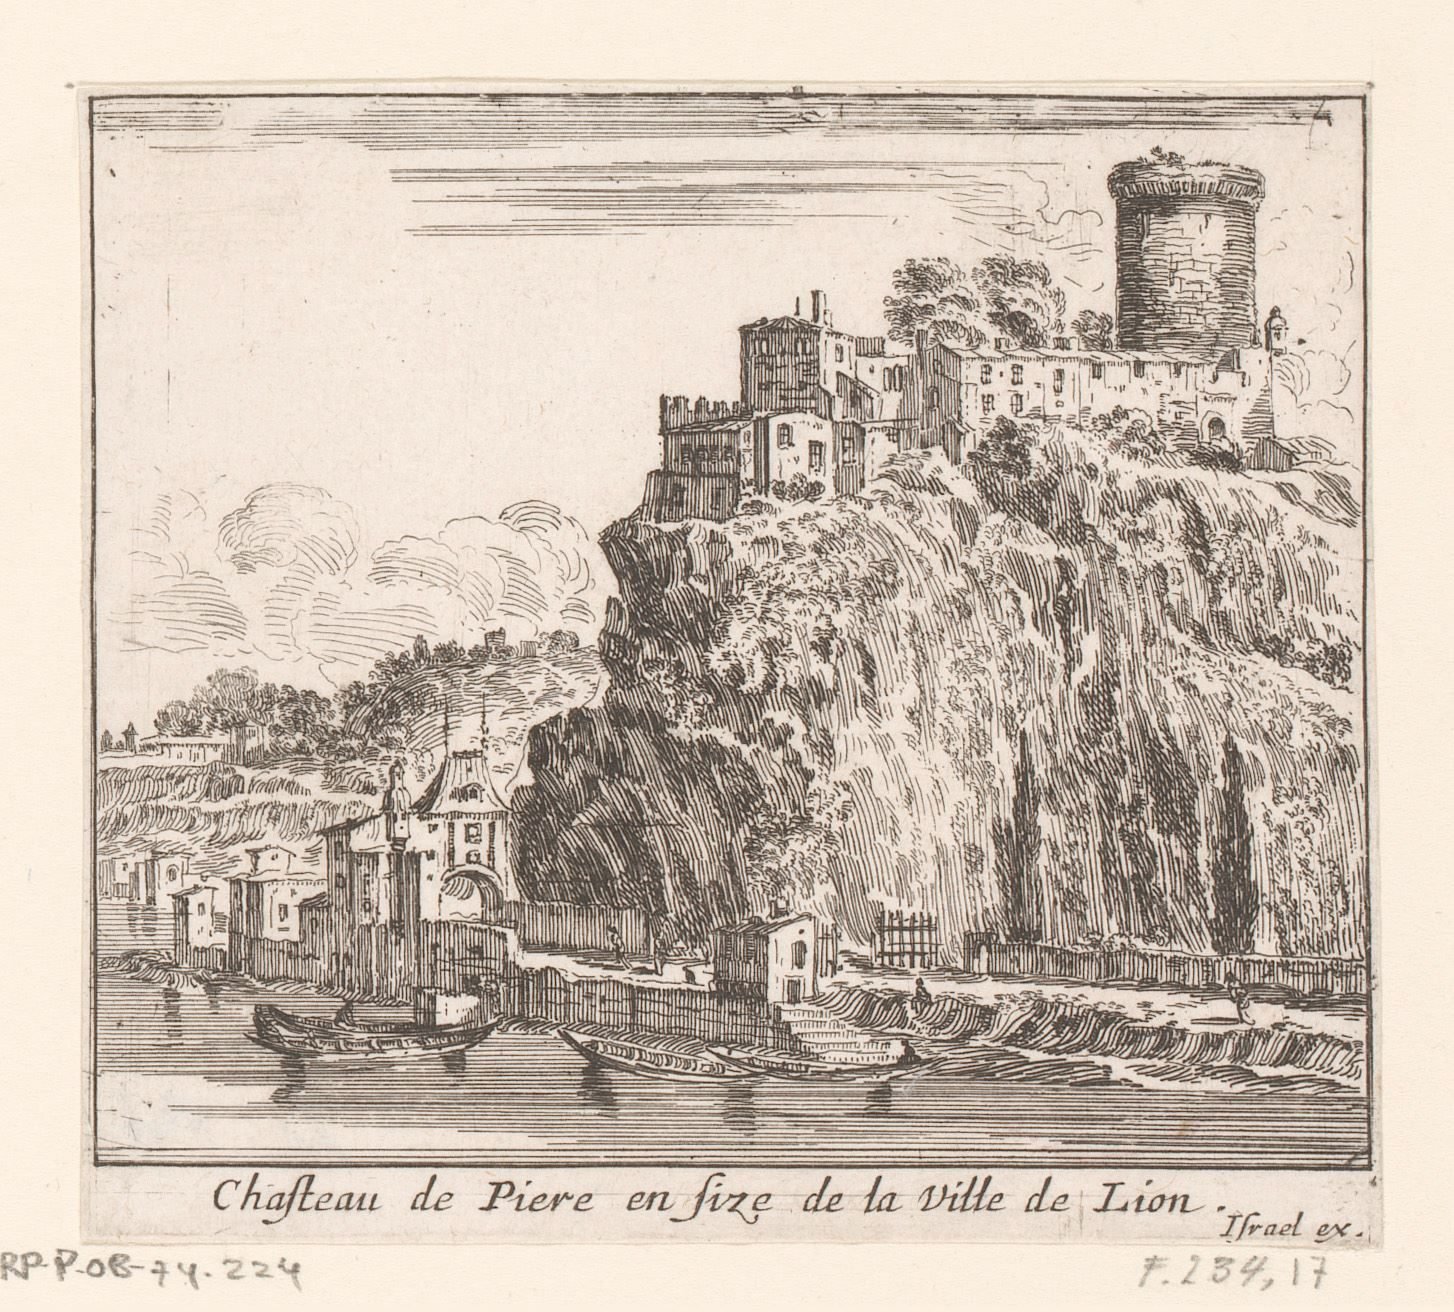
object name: print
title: Gezicht op kasteel Pierre Scize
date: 1652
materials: paper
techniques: engraving, etching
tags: landscape with tower or castle, lyon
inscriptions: collector's mark: Lugt 240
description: Prent maakt deel uit van een ongenummerde serie van dertien prenten.